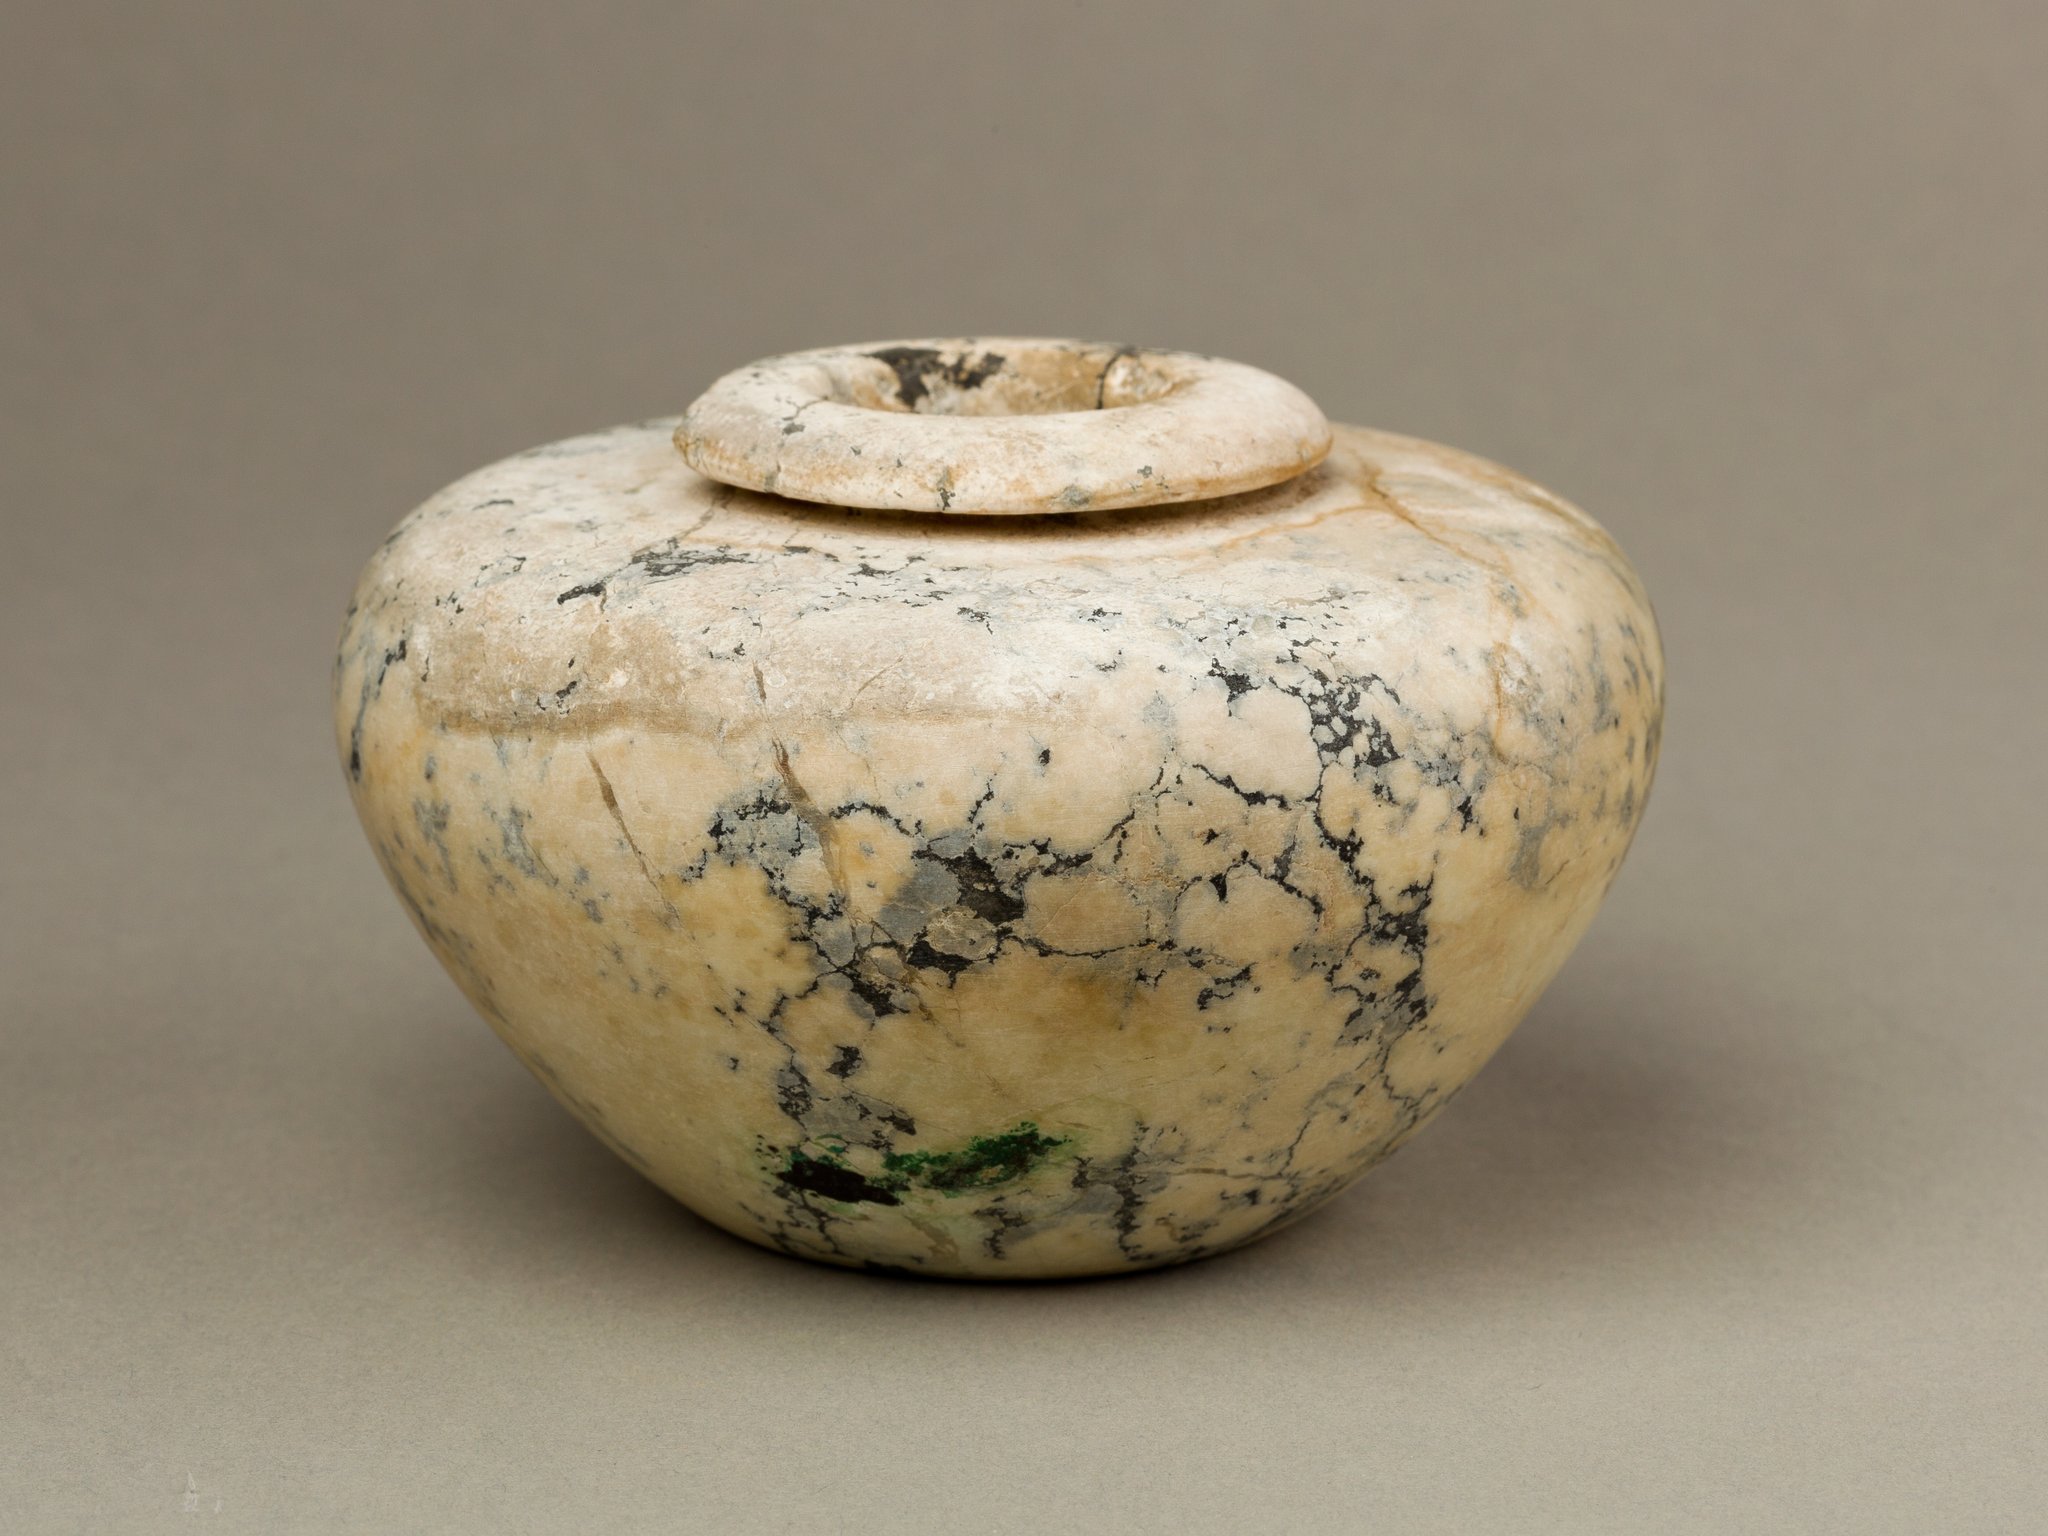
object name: jar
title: Squat jar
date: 2650 BCE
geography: egypt